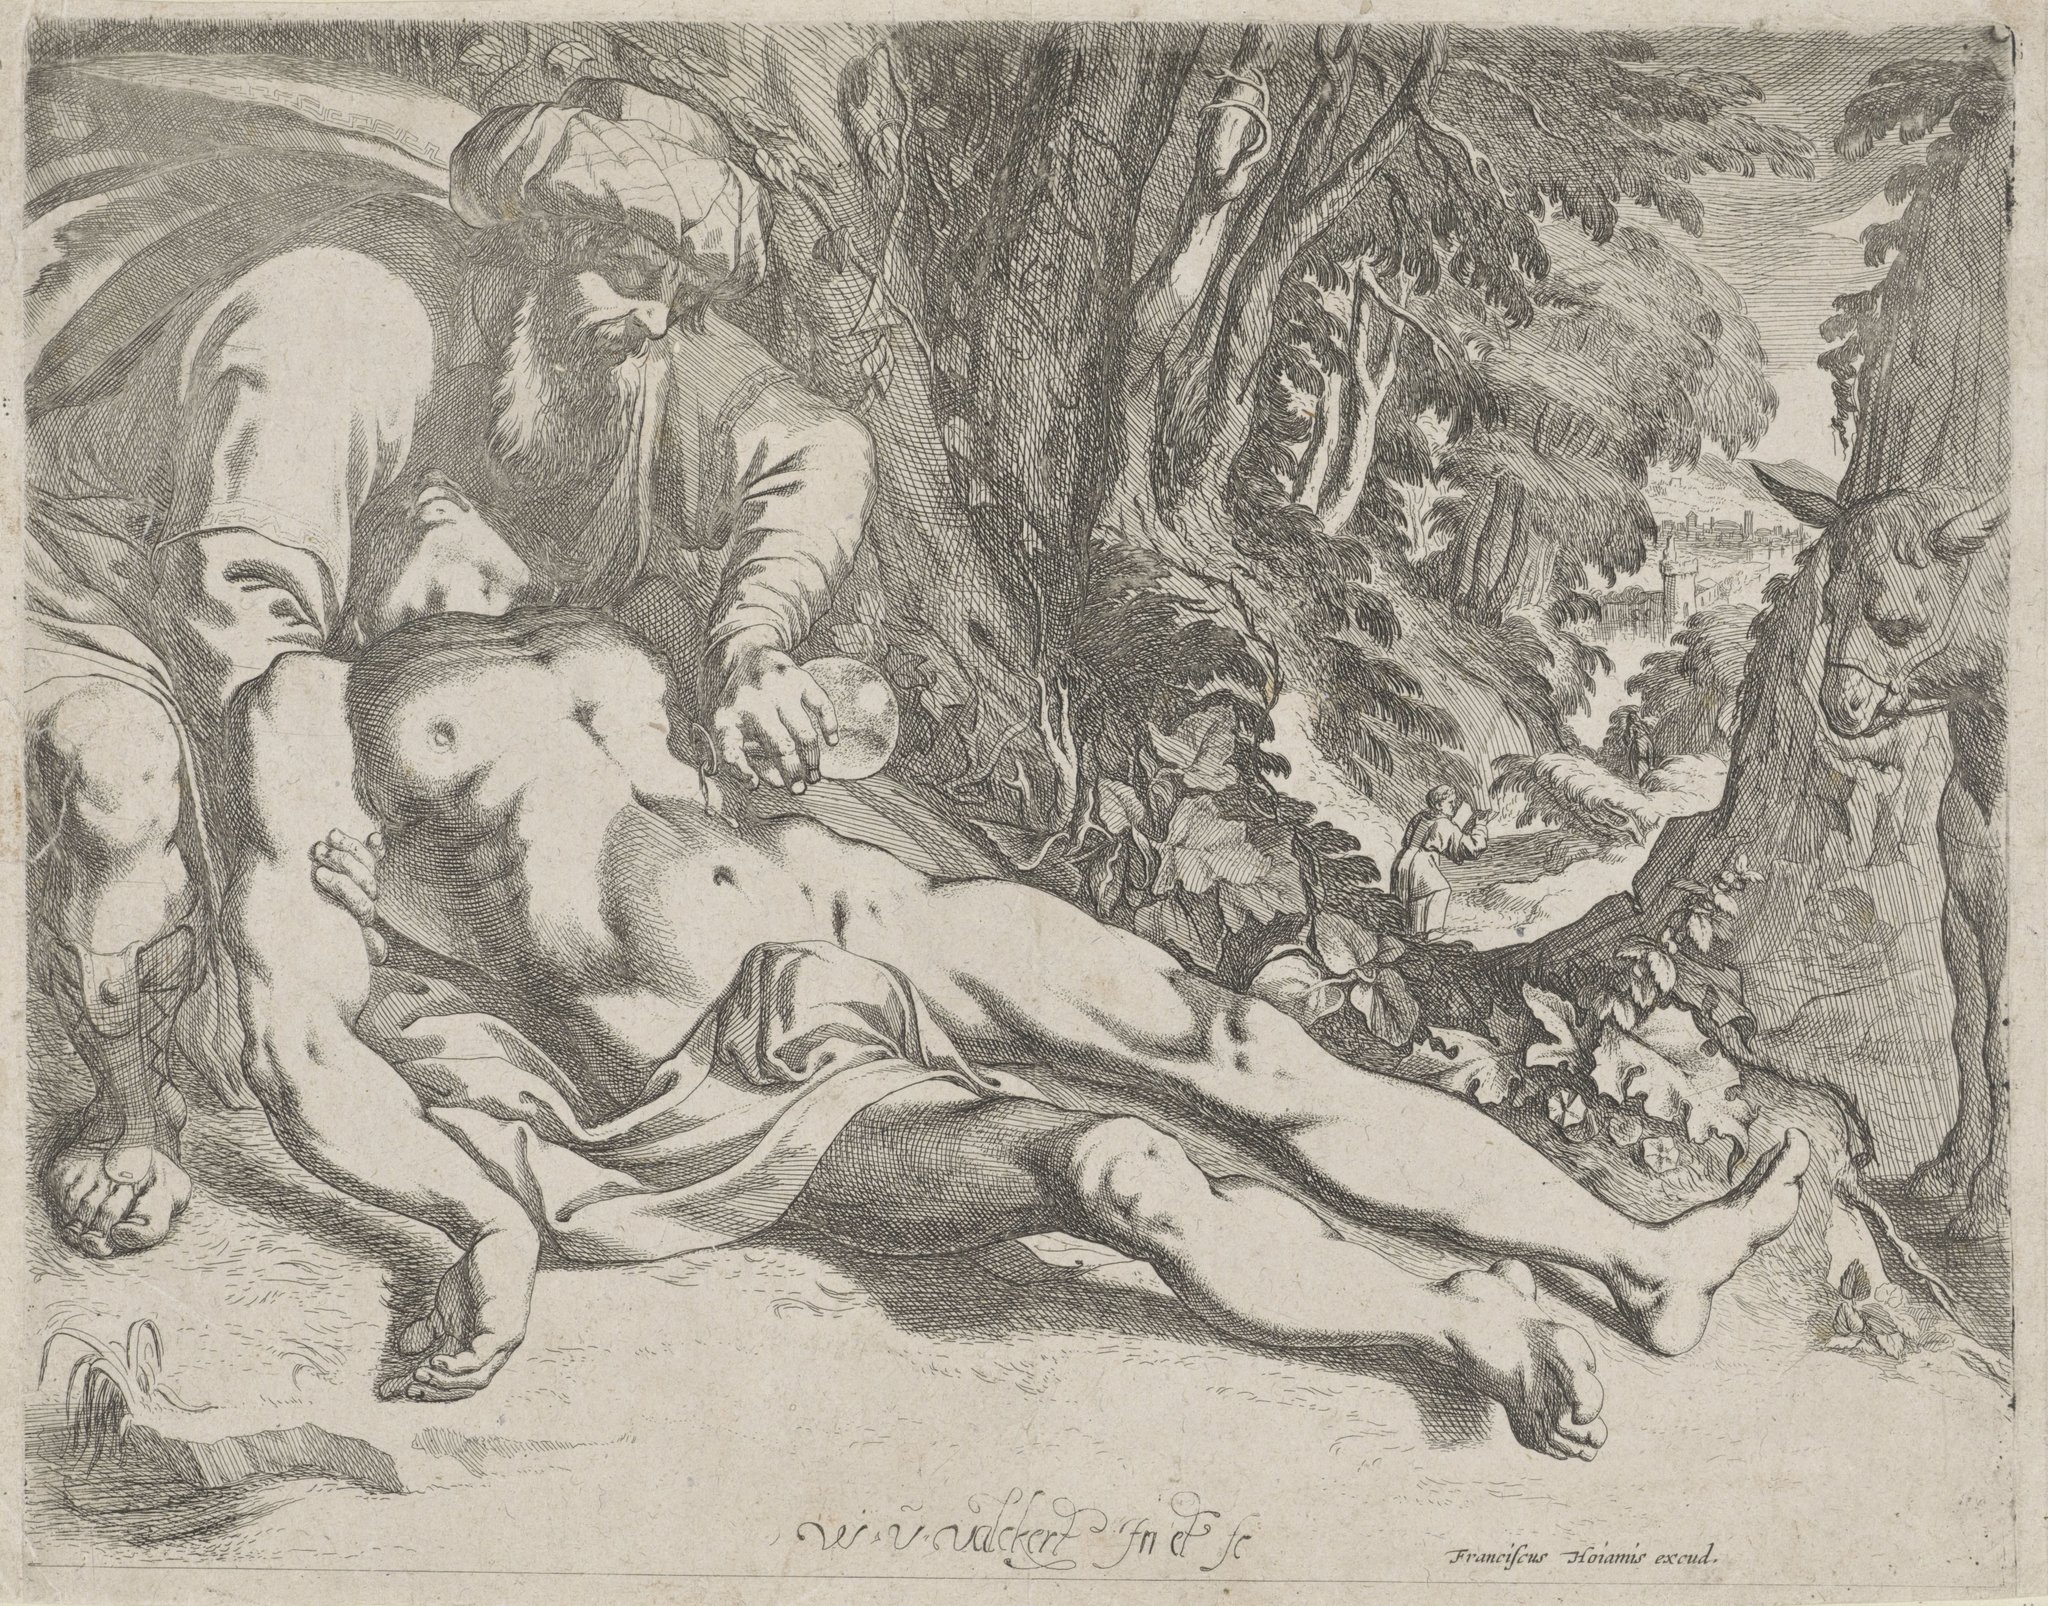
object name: print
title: De barmhartige Samaritaan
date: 1595-1645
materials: paper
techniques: engraving, etching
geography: northern netherlands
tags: a samaritan tending the wounds of the traveller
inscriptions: collector's mark: Lugt 240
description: De barmhartige Samaritaan verzorgt de wonden van de reiziger .